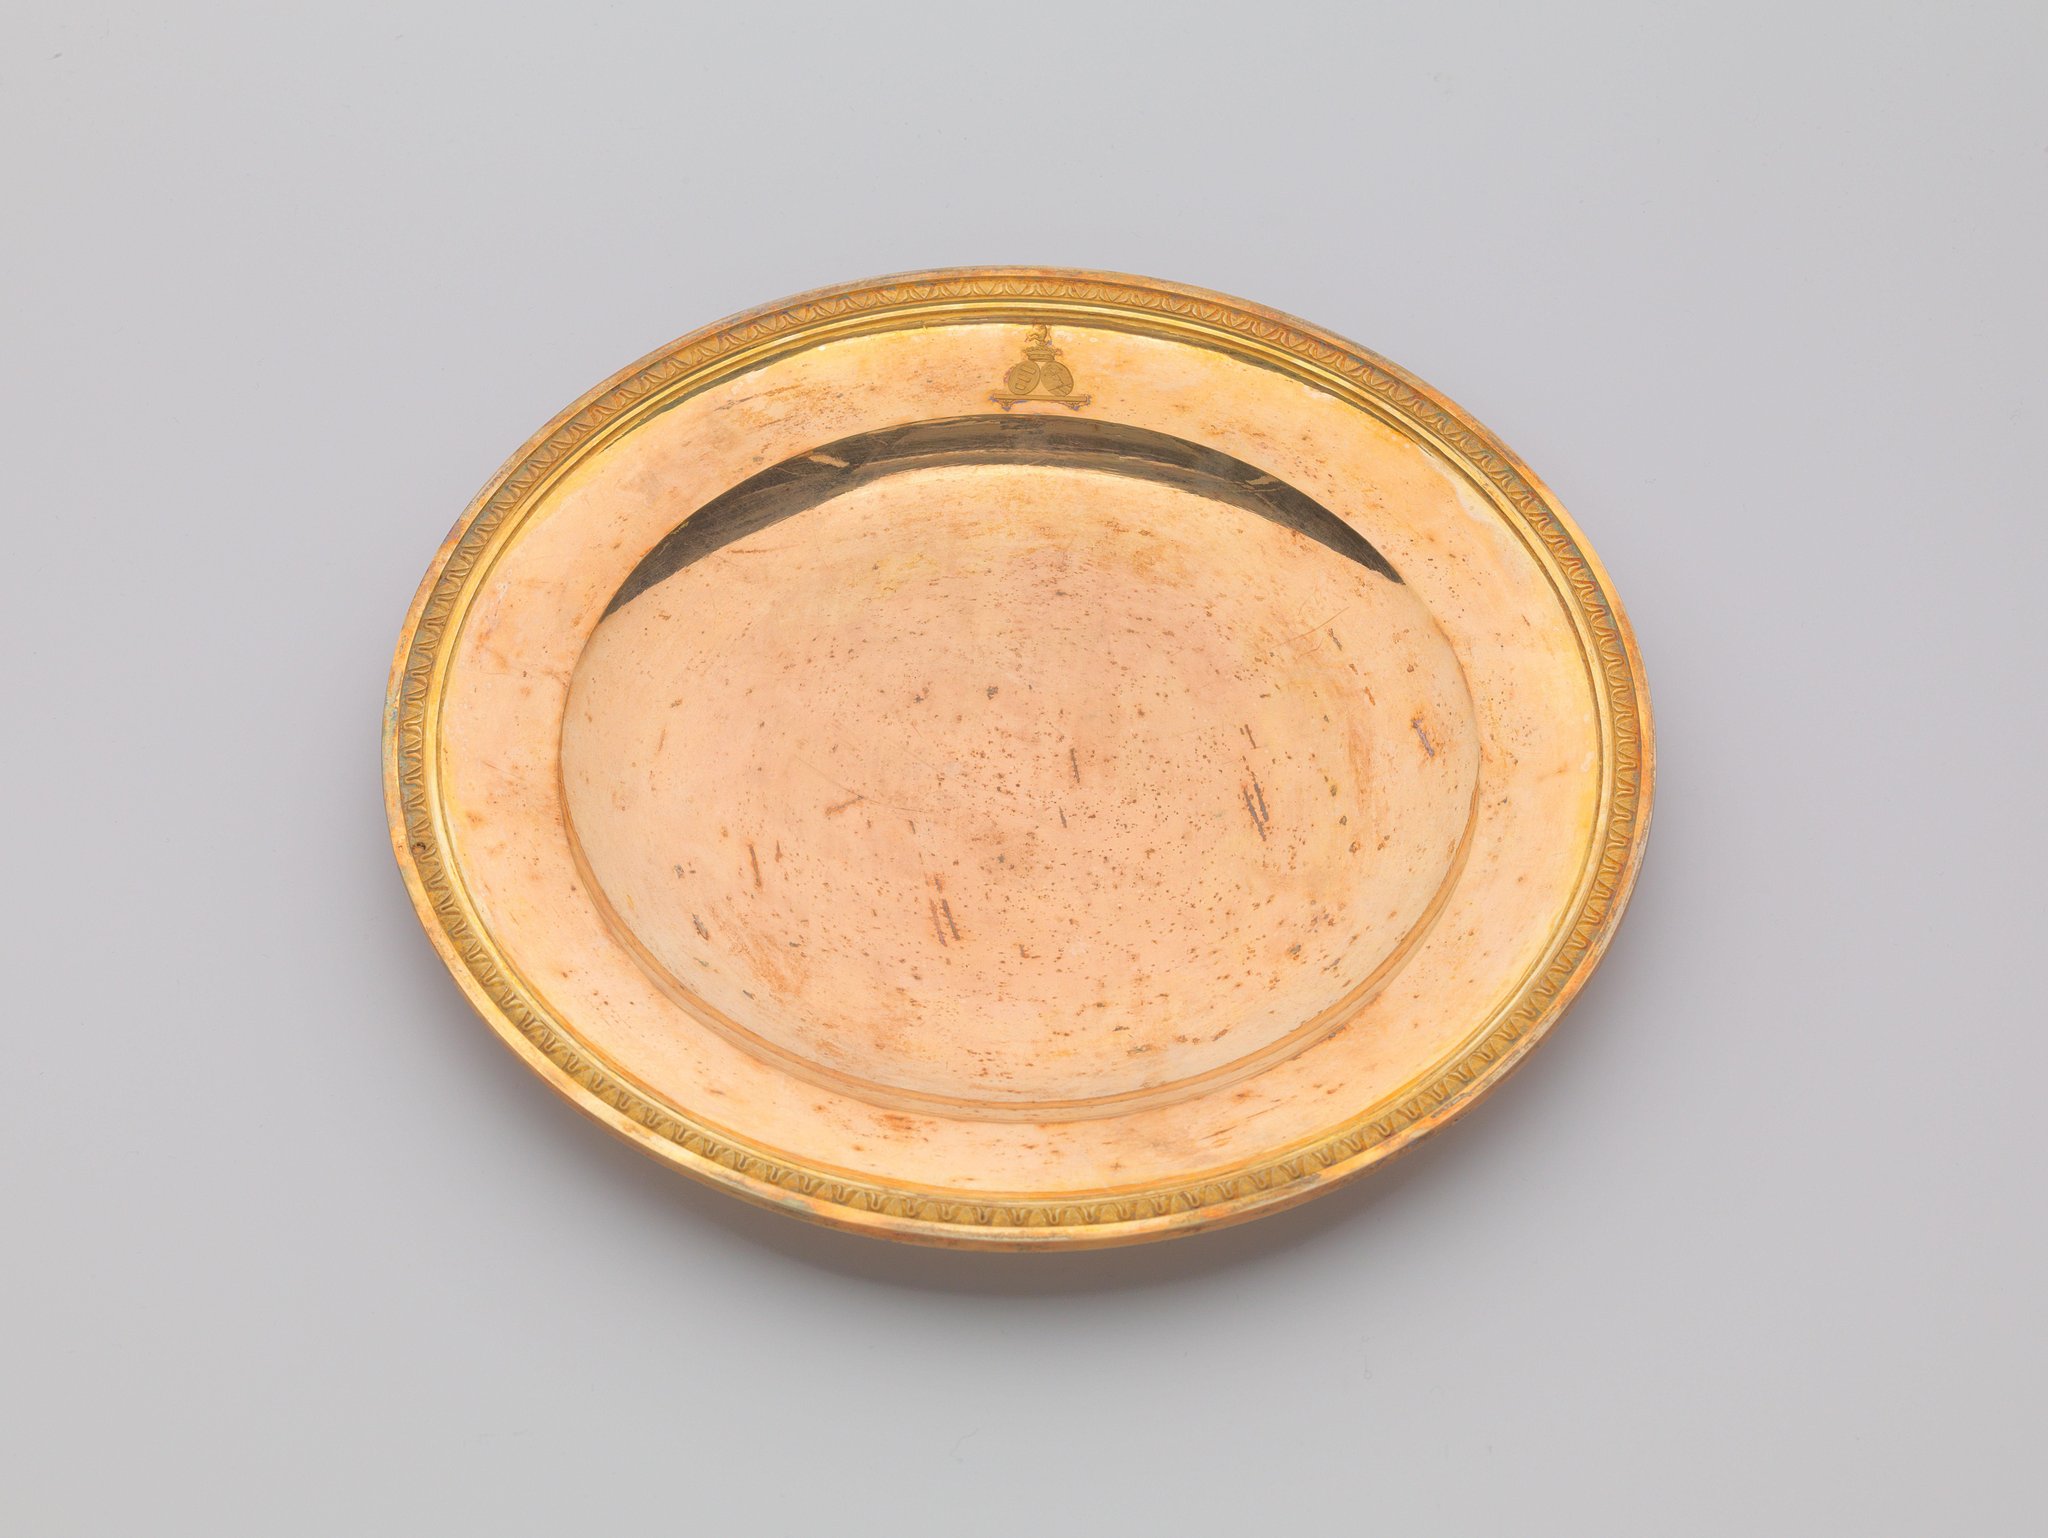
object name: plate dish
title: bord van verguld zilver, met palmetrand. Op het plat het gegraveerde wapen Potemkin.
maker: Anonymous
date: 1809-1819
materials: silver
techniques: gilding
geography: paris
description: Empire bord van verguld zilver. Omgeven door een palmetrand. In het plat het gegraveerde wapen van Potemkin.